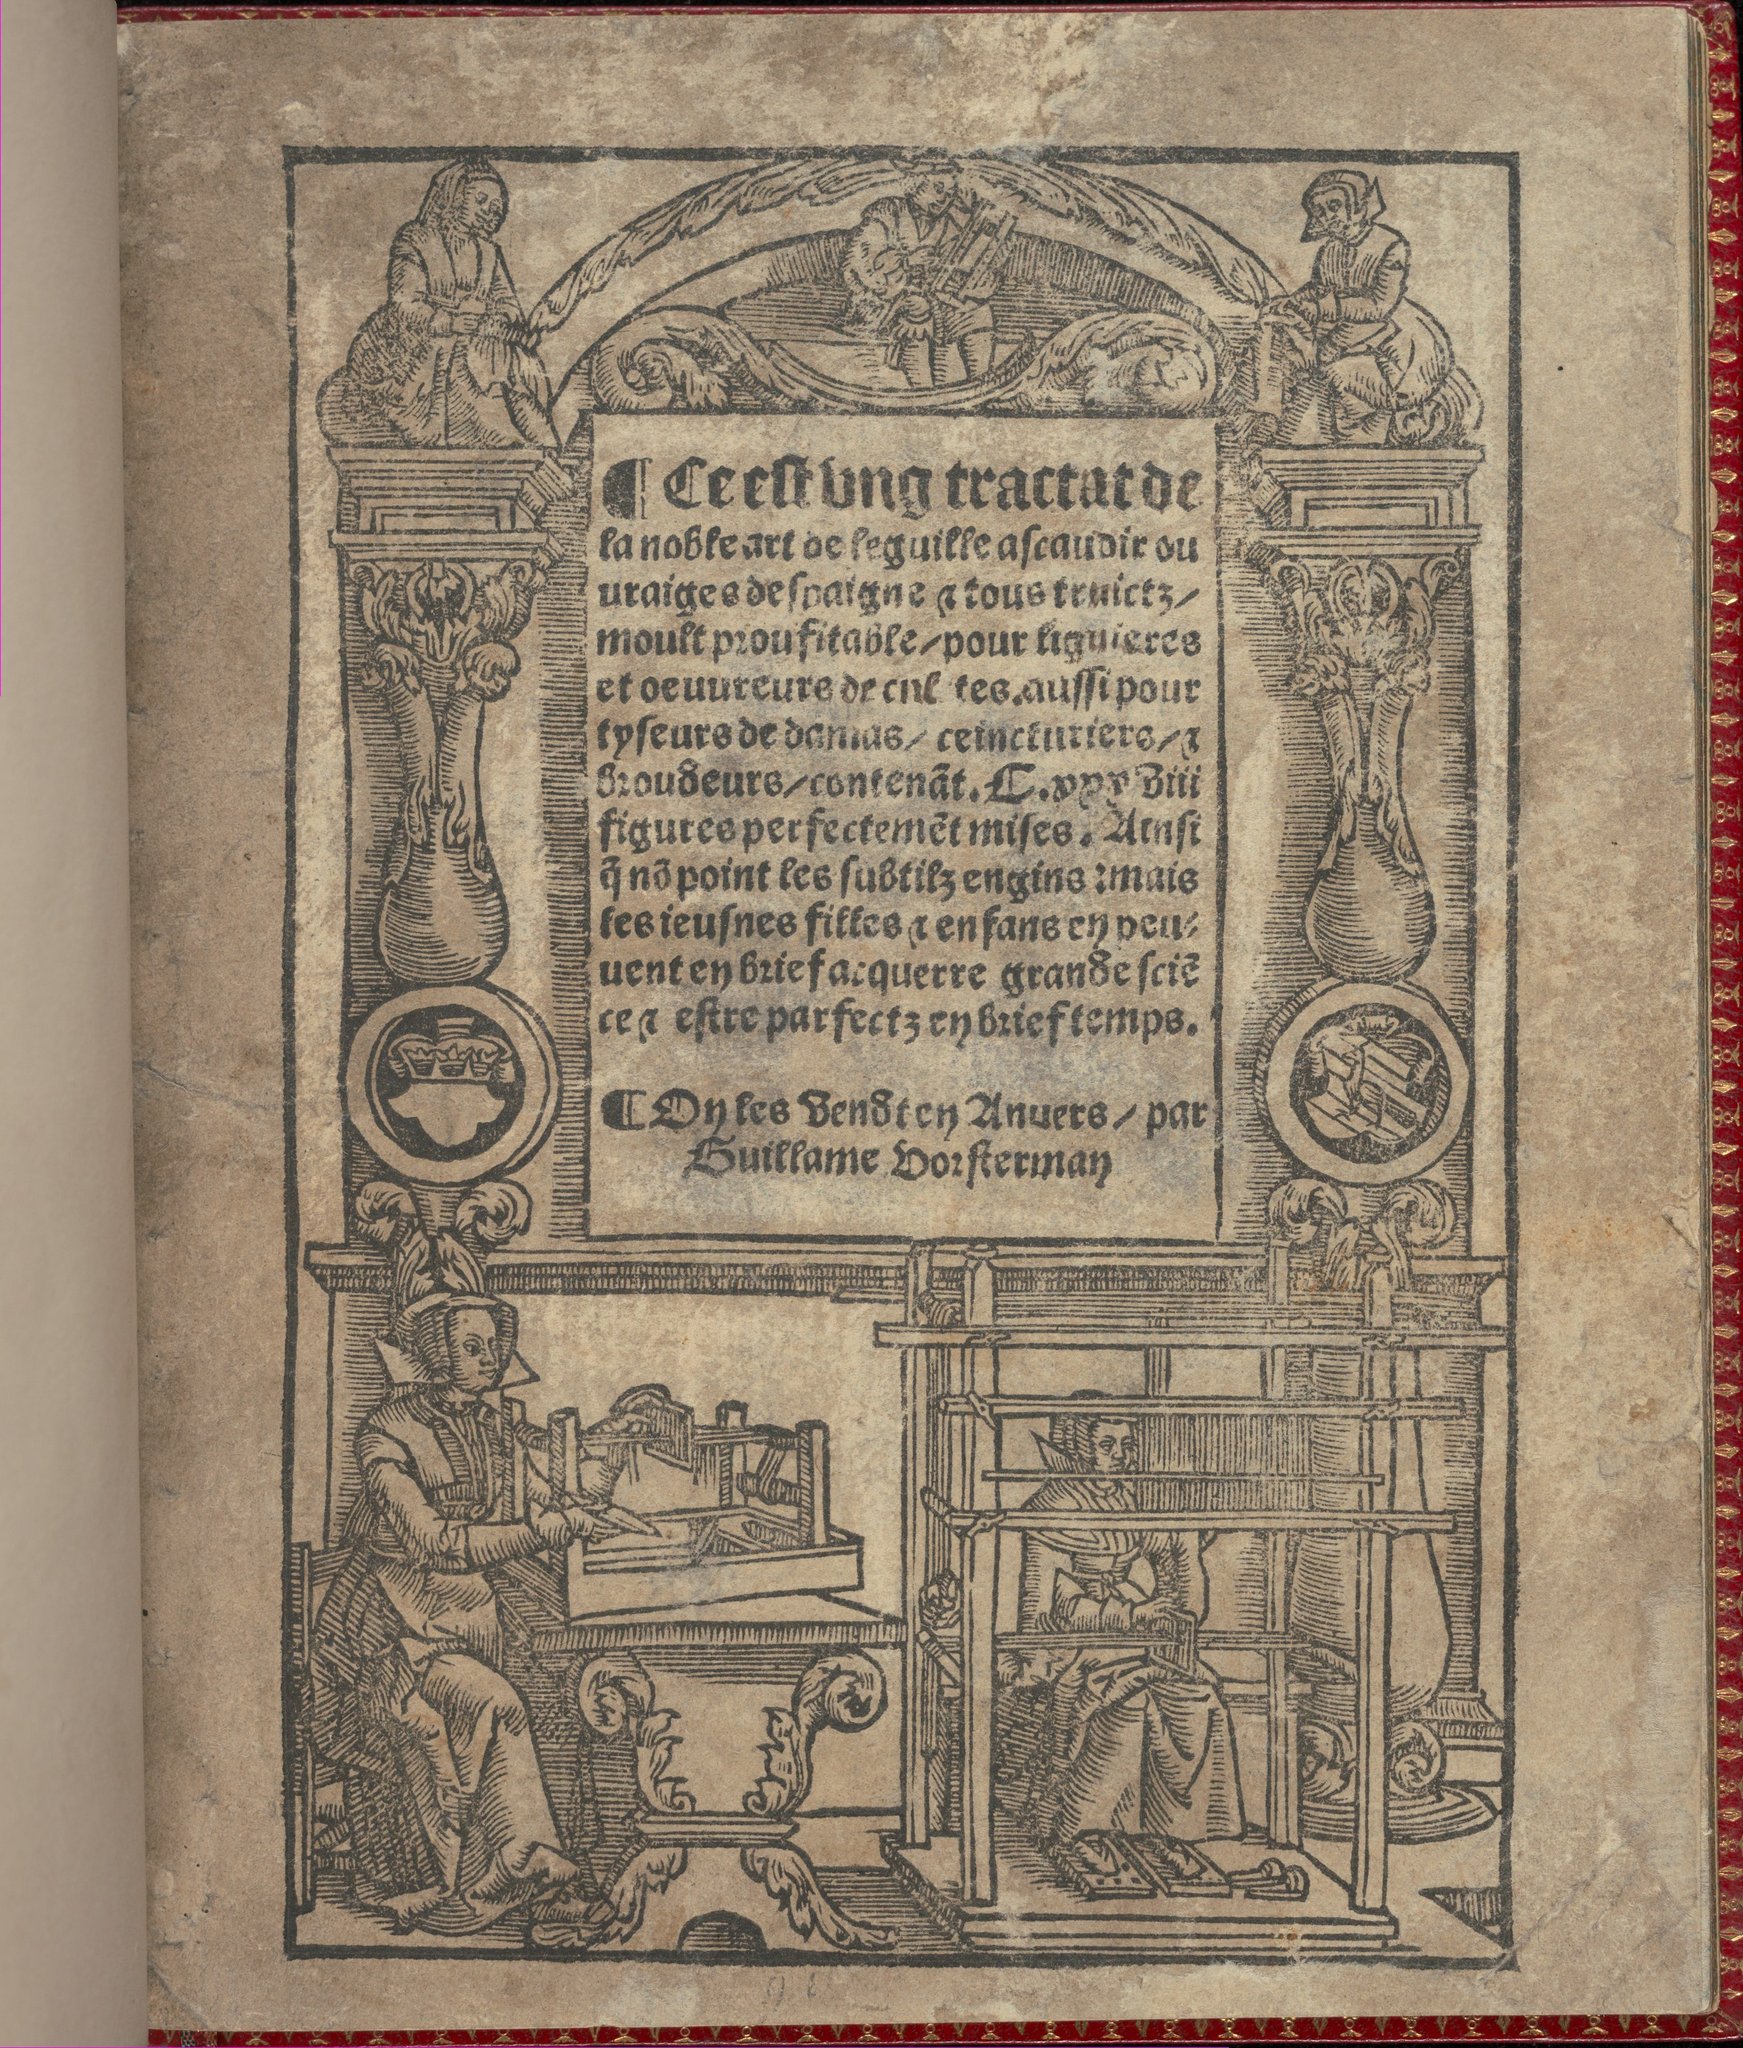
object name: book print ornament architecture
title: Ce est ung tractat de la noble art de leguille ascavoir ouvraiges de spaigne... title page (recto)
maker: willem vorsterman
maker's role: printer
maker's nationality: netherlandish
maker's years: 1500-1550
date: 1527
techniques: woodcut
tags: men,women,looms